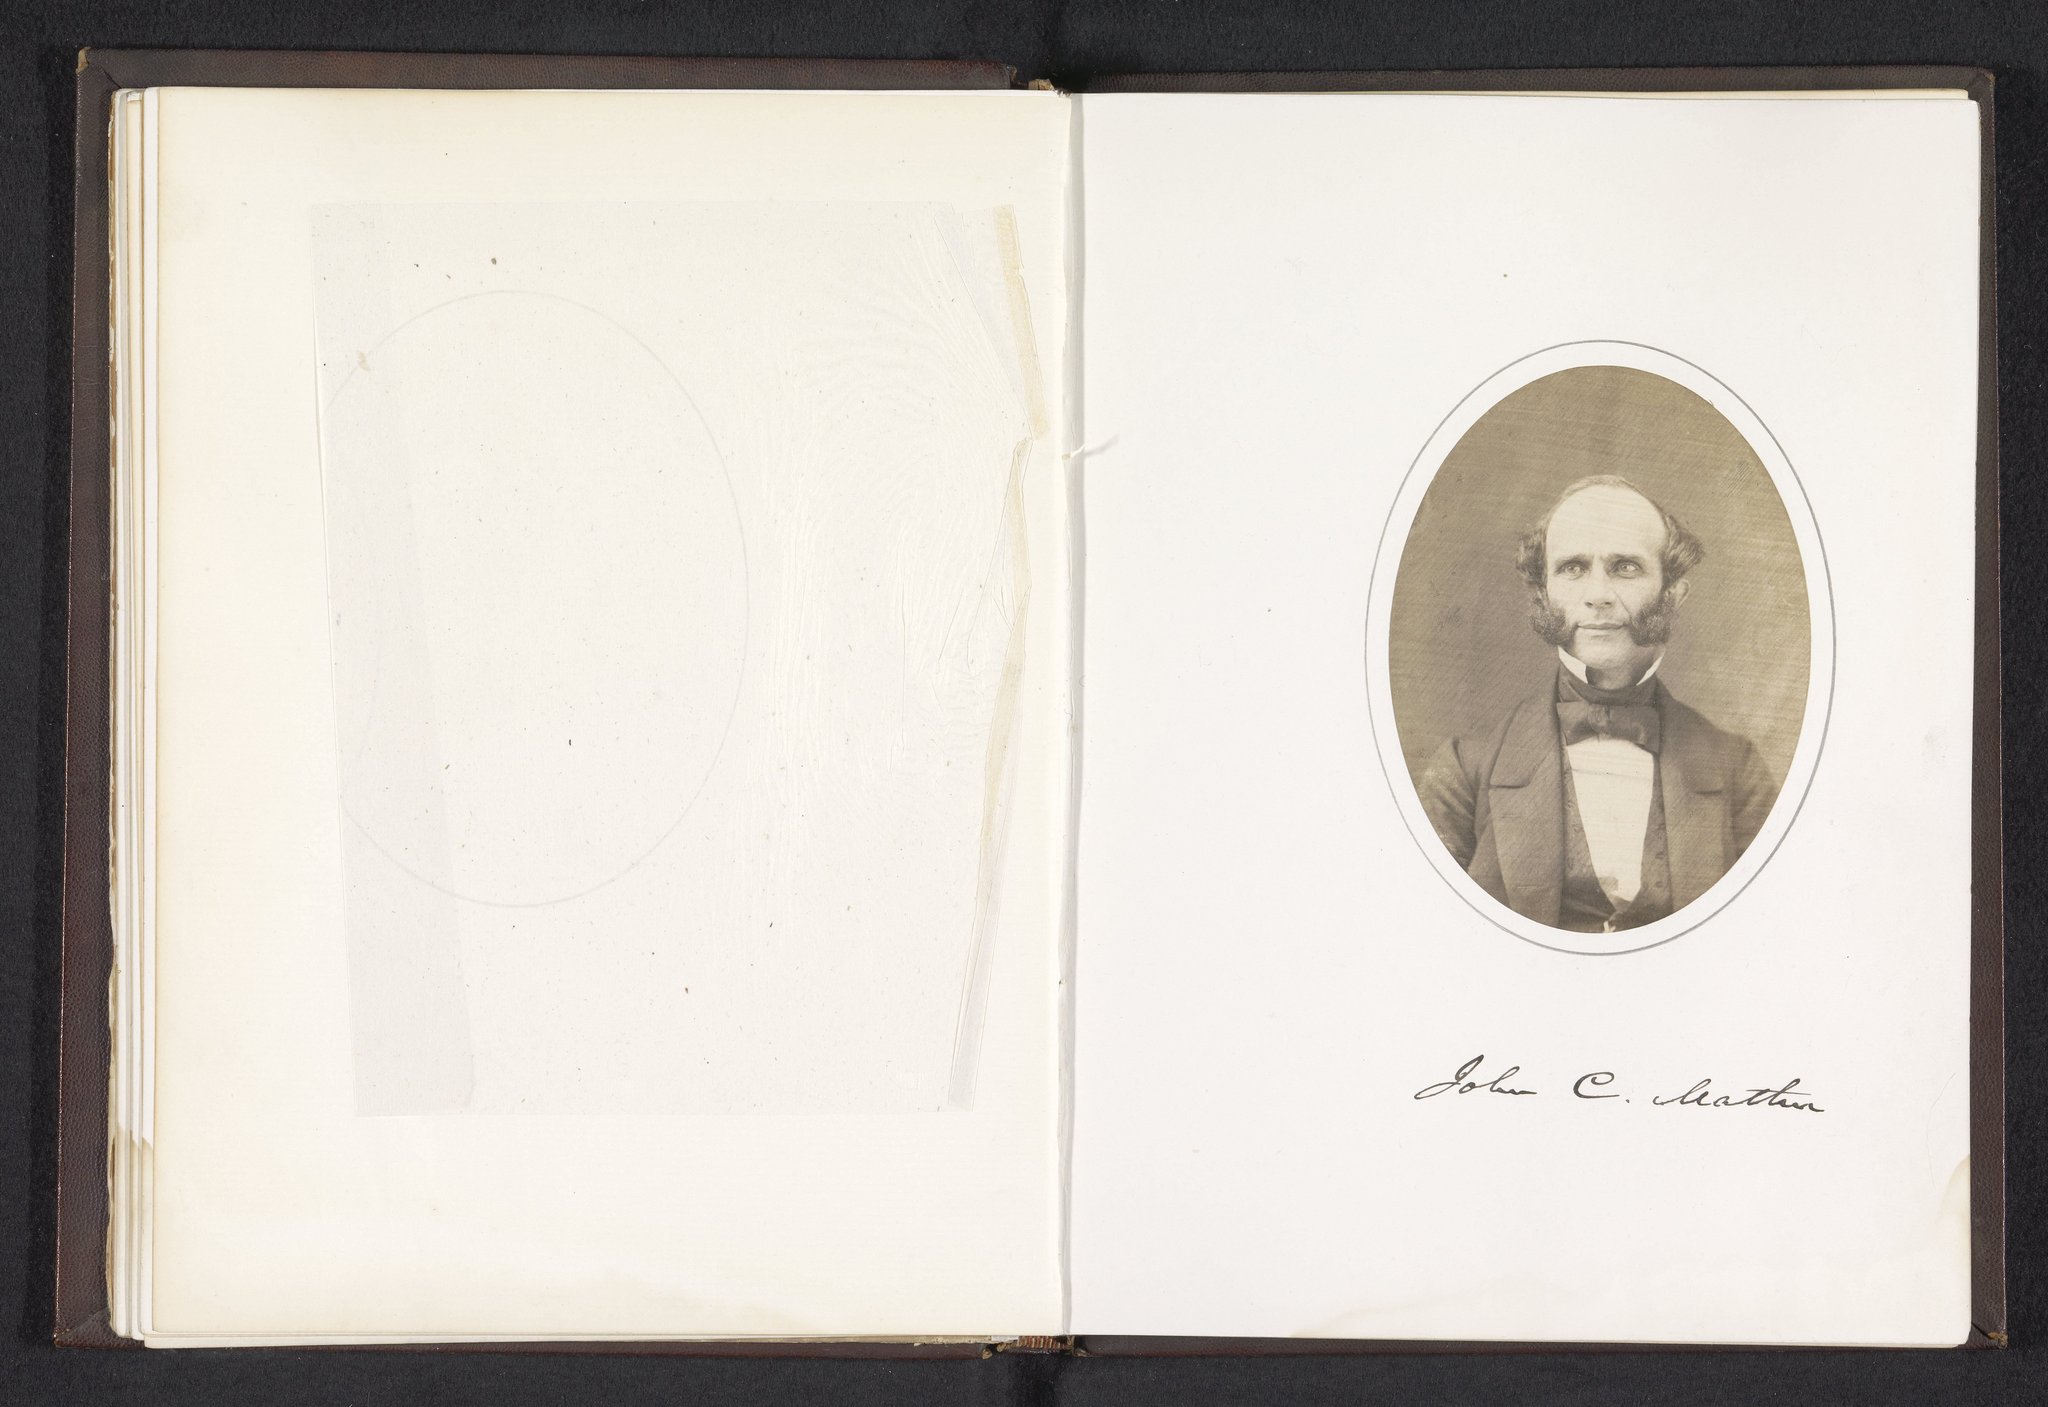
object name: photograph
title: Portret van Senaatslid John C. Mather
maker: d.t.t. davie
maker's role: publisher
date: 1858-1859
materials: photographic support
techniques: salted paper print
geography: new york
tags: politician, e.g. party leader, upper house, senate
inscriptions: inscription: ‘John C. Mather’